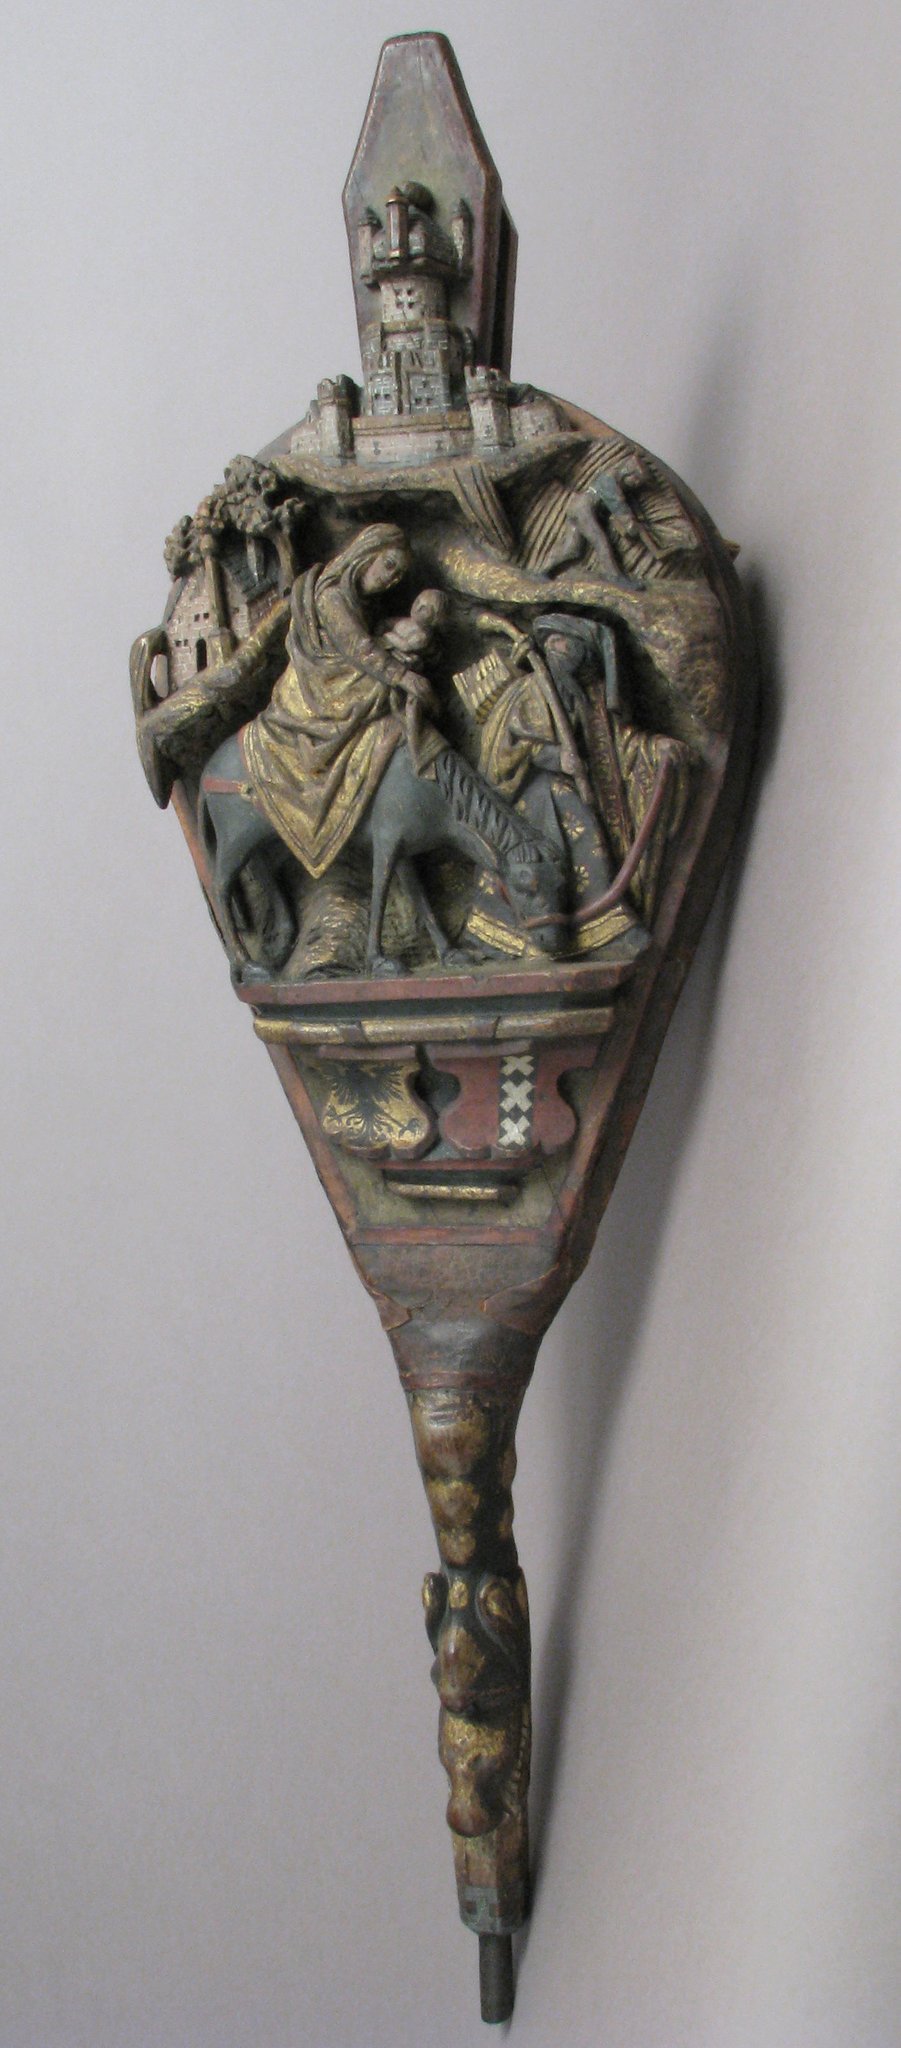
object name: bellow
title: Bellows with the Flight into Egypt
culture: dutch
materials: leather, wood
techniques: gilding, polychromy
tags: infants,women,horses